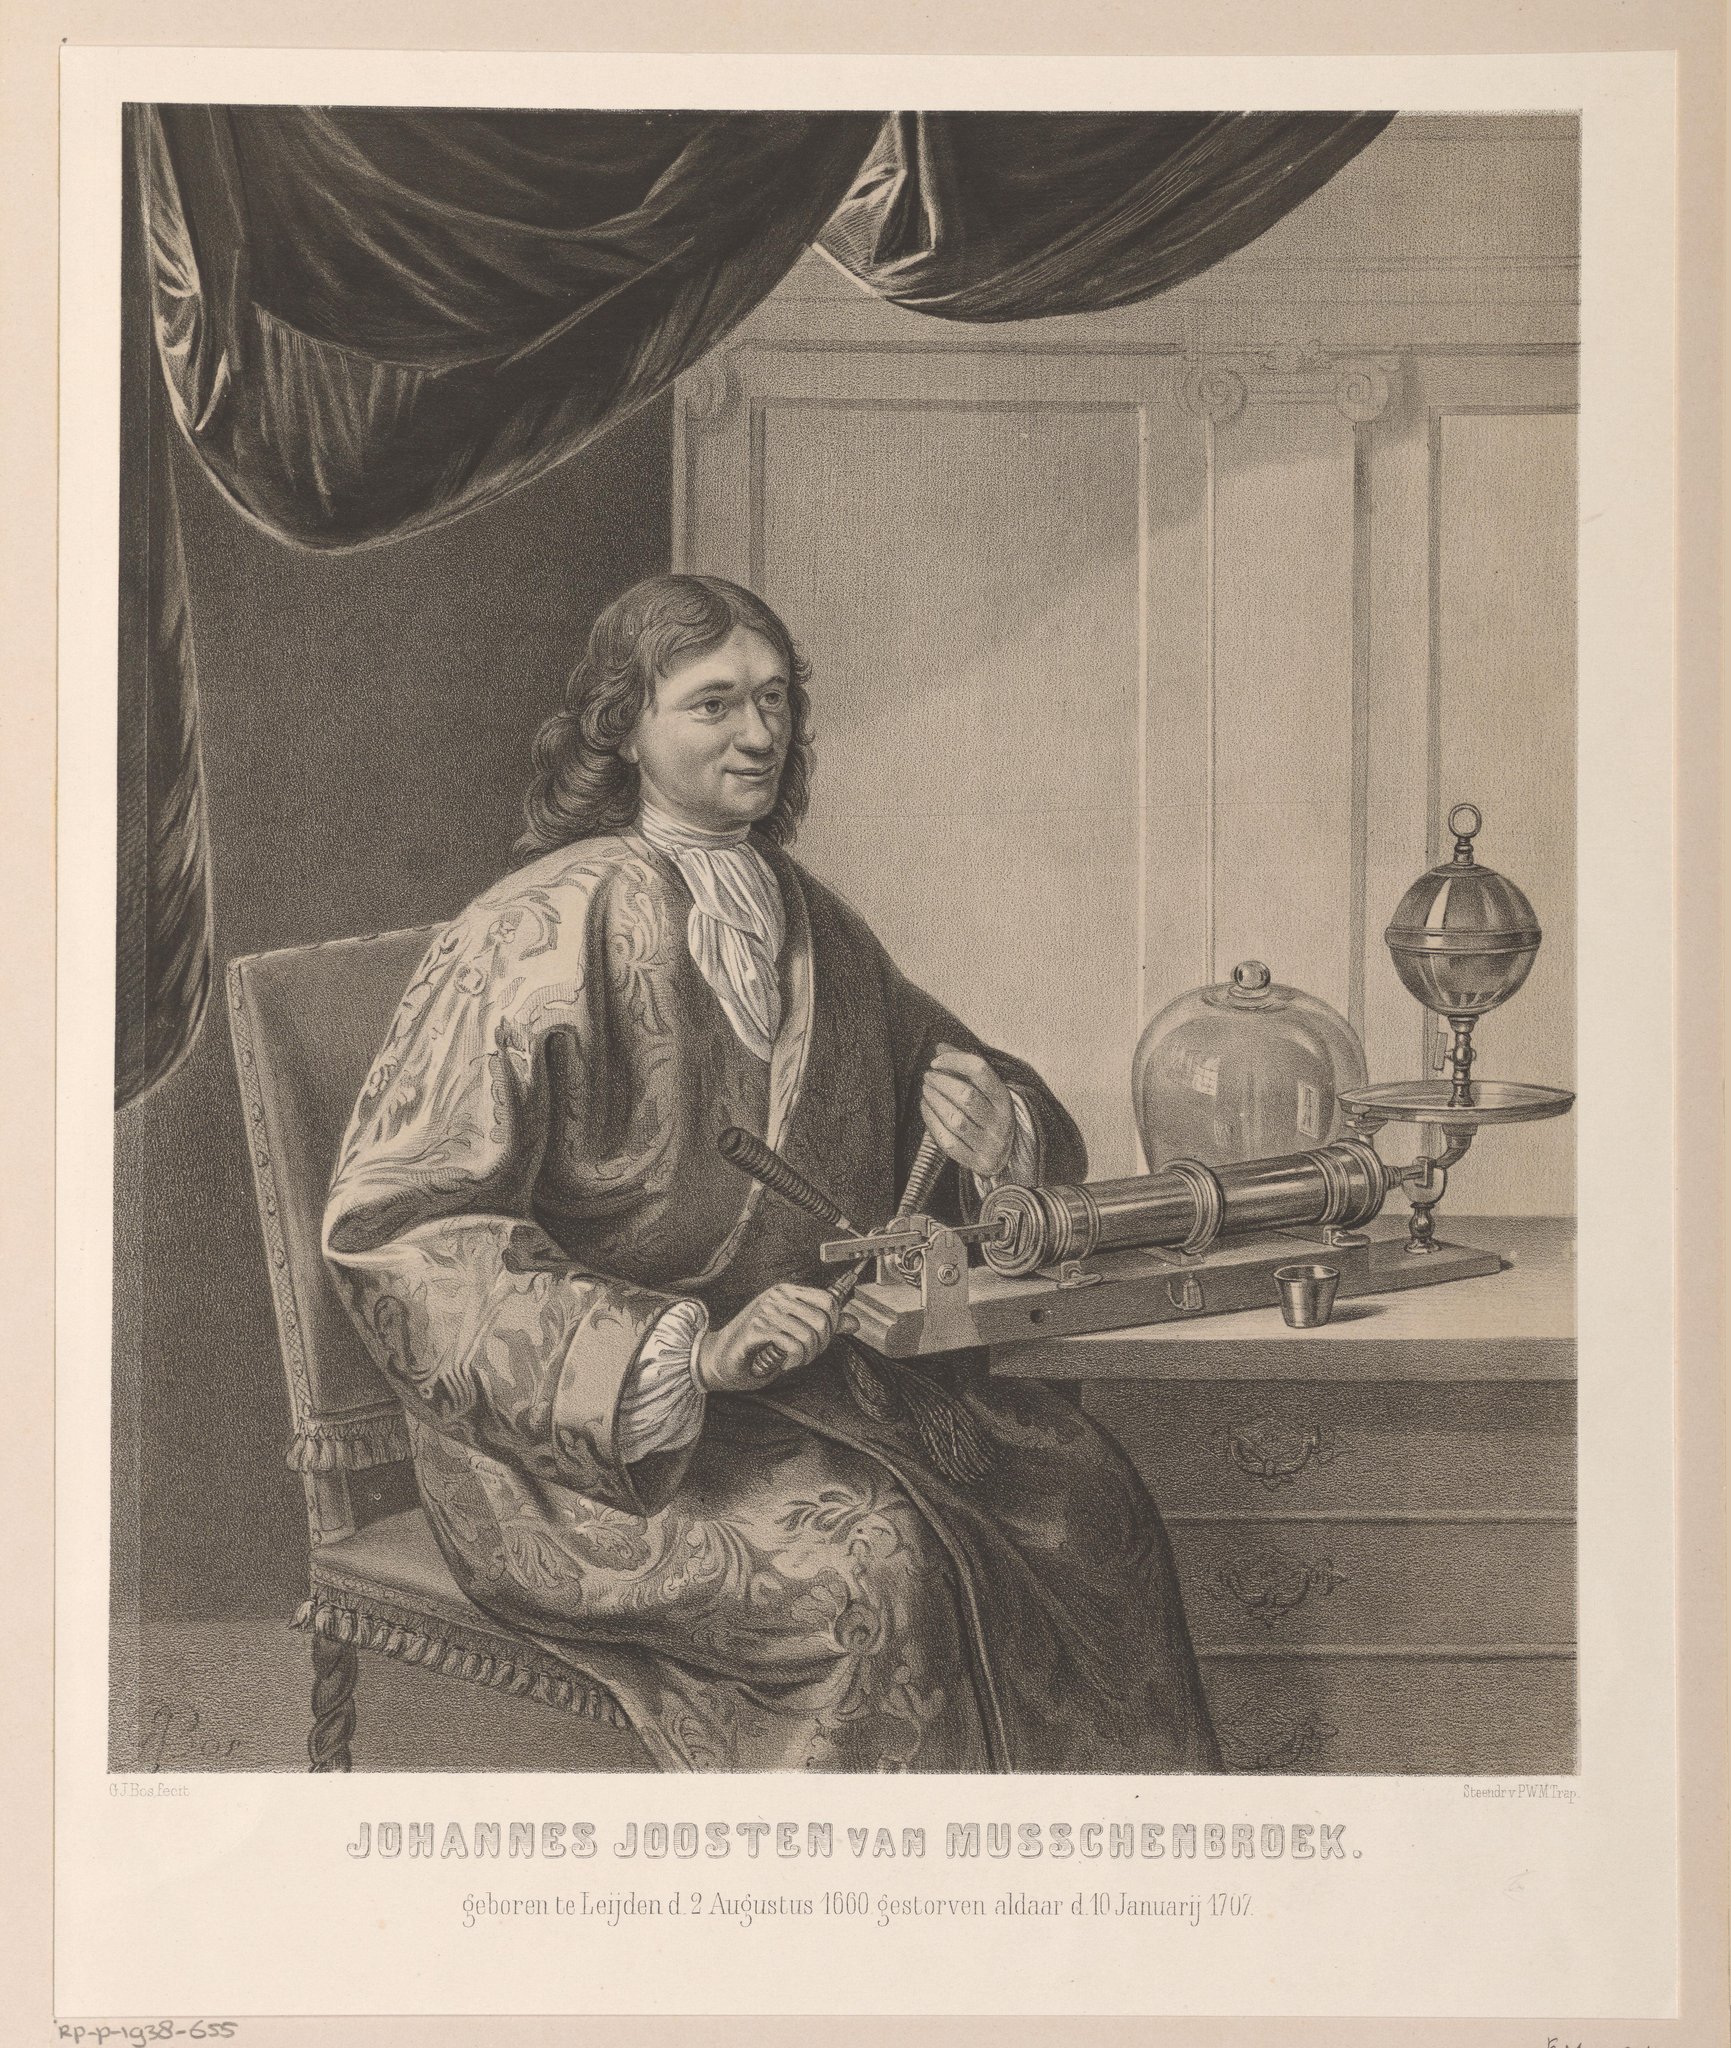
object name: print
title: Portret van Johannes Joosten van Musschenbroek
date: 1840-1898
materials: paper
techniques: tone lithography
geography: leiden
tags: instrument maker, glass bell, glass cover ~ horticulture, historical persons, measuring-instruments, bath-robe, dressing-gown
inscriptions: collector's mark: Lugt 2228